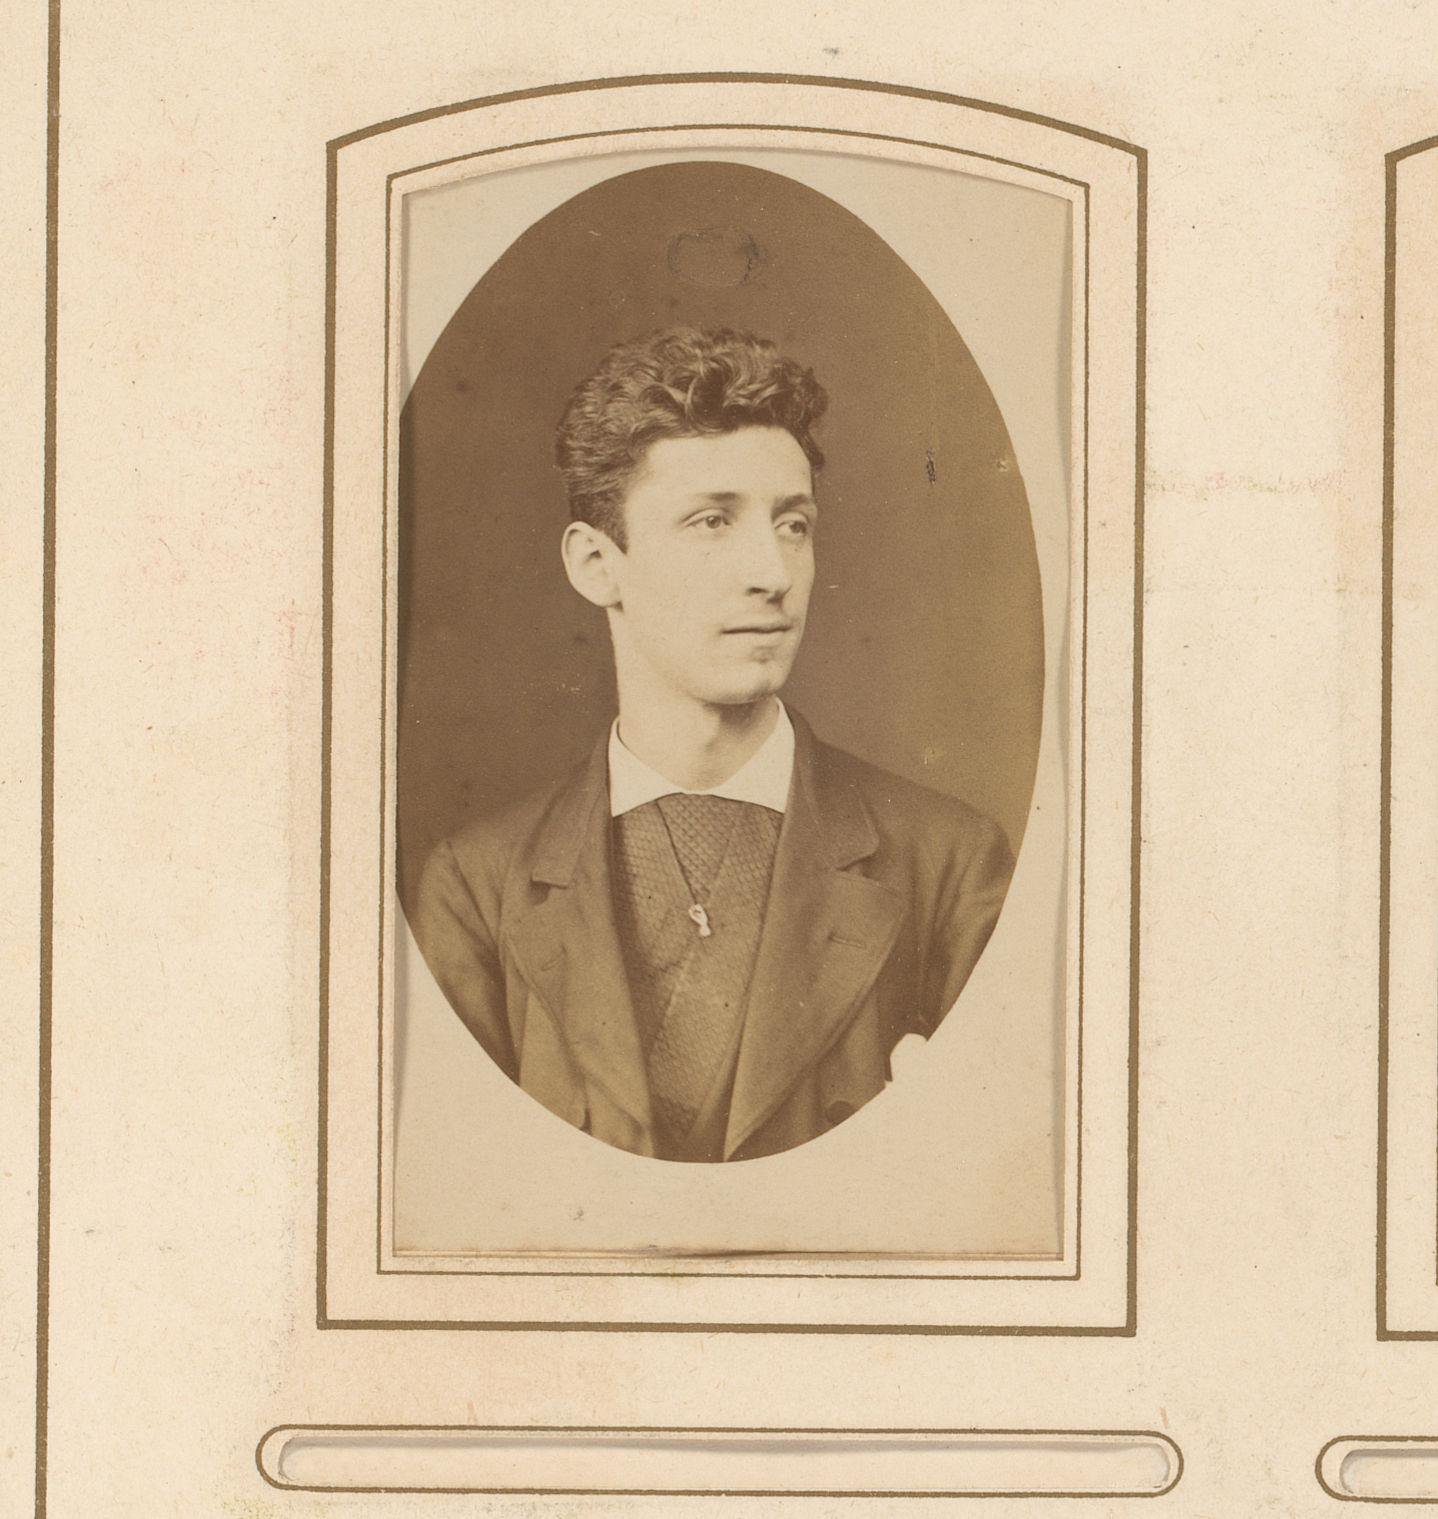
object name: photograph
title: Portret van een man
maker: Anonymous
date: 1860-1875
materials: cardboard, paper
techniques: albumen print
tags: adult man, historical persons